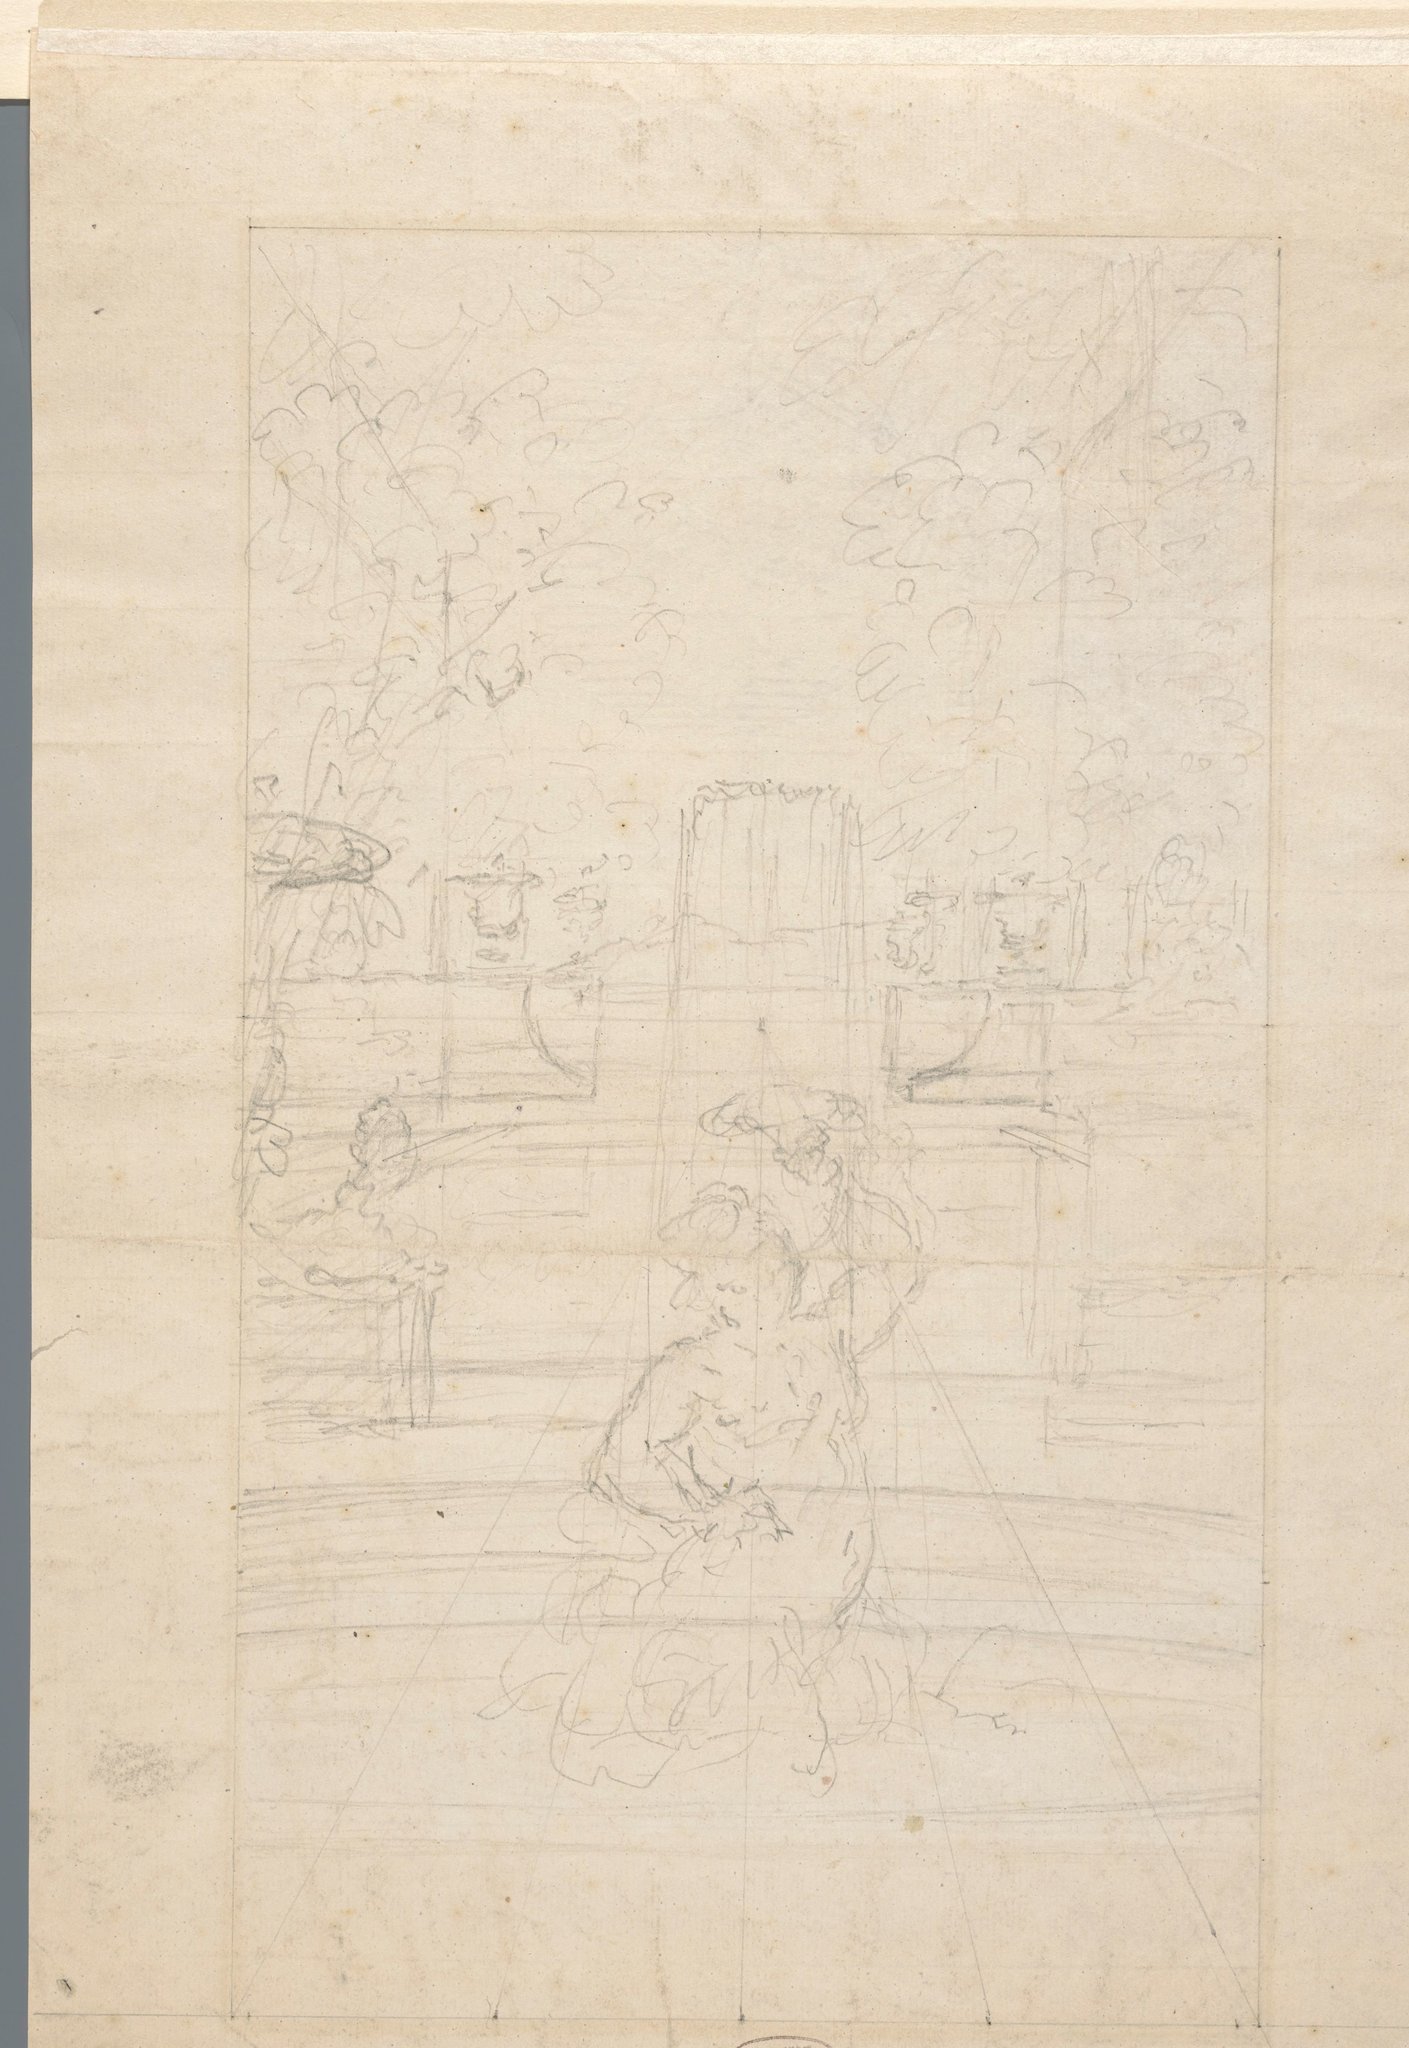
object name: design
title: Gezicht op een tuinvijver en een fontein met triton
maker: dionys van nijmegen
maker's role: draughtsman, painter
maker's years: 1705-1798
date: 1715-1798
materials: paper, pencil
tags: triton(s), garden, garden fountain, piece of sculpture, reproduction of a piece of sculpture